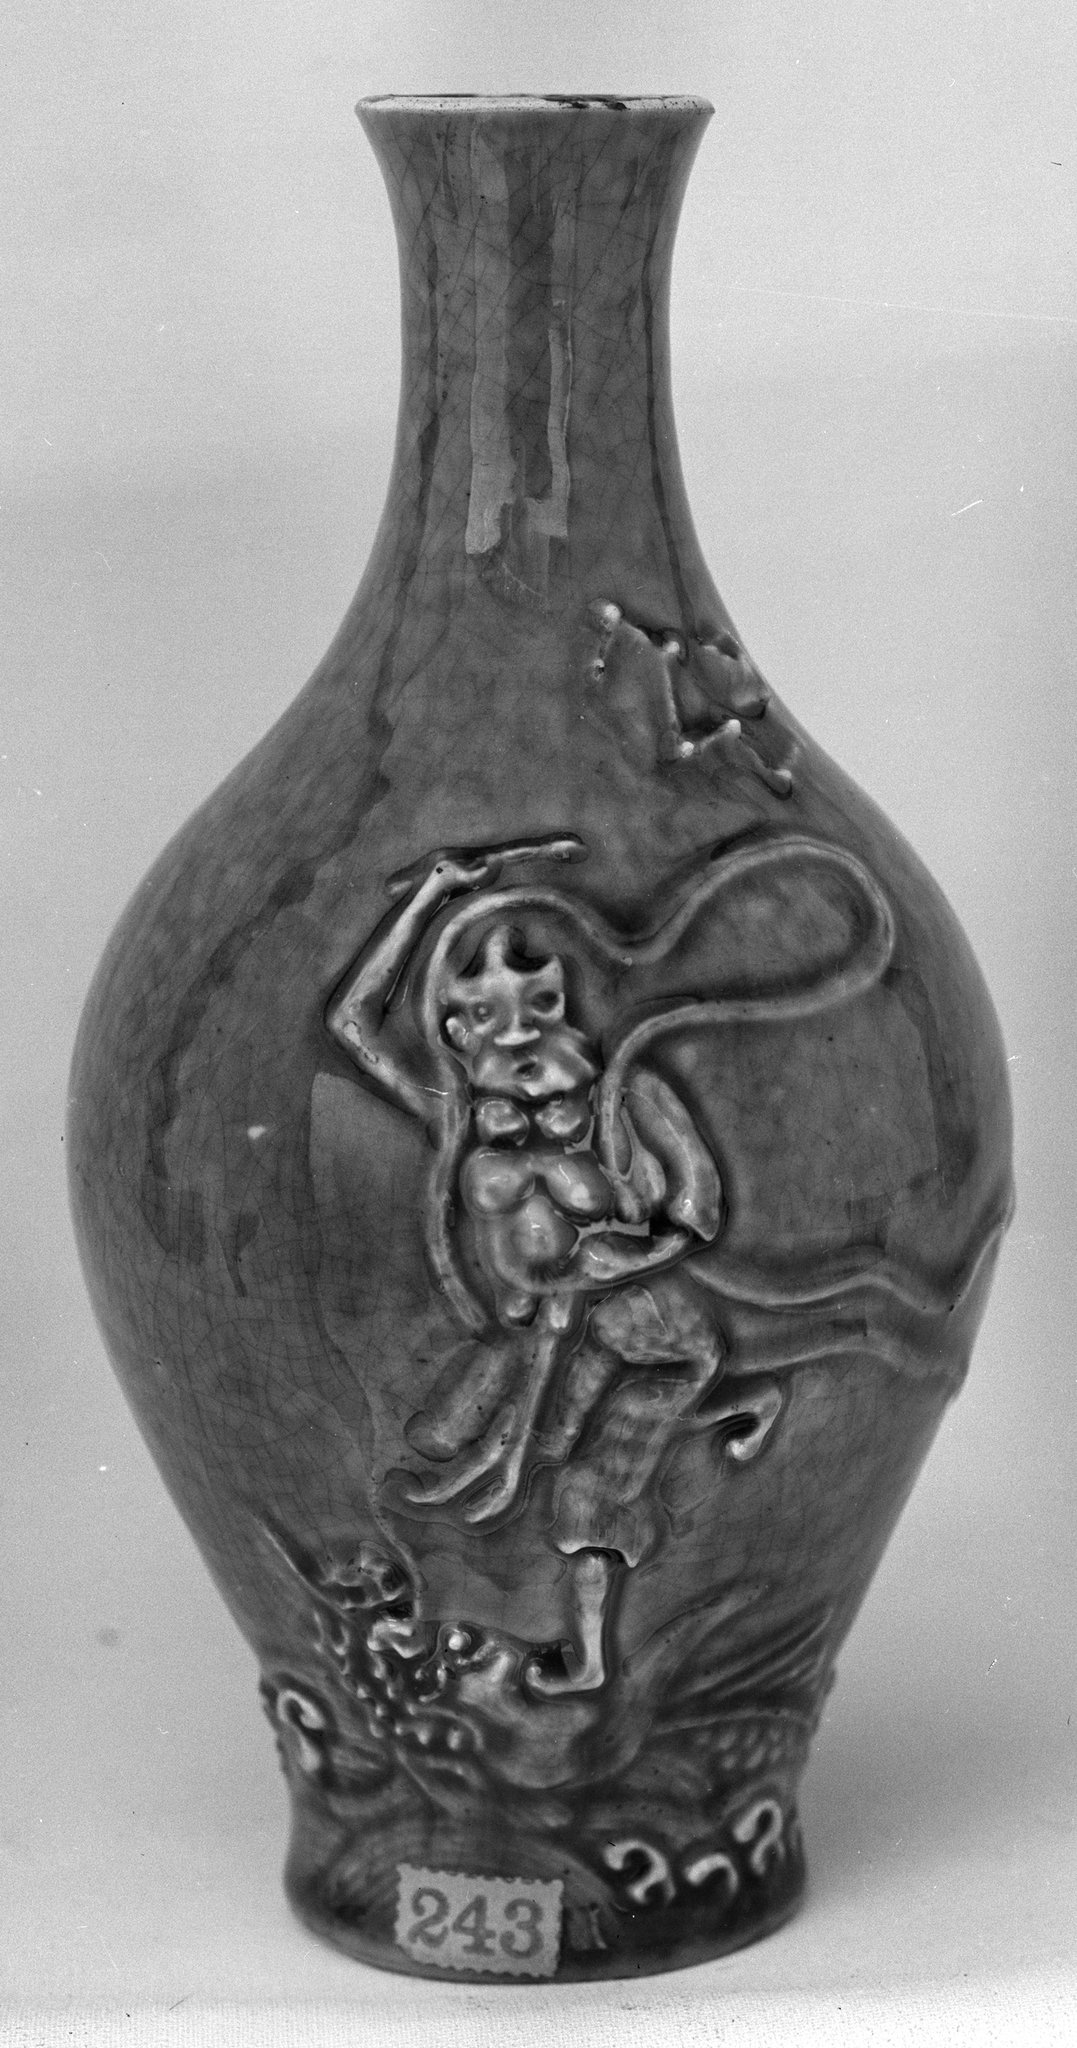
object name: vase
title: Vase with the Pole Star deity (Kuixing)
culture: chinese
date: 1801-1850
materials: glaze, porcelain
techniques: relief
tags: deities